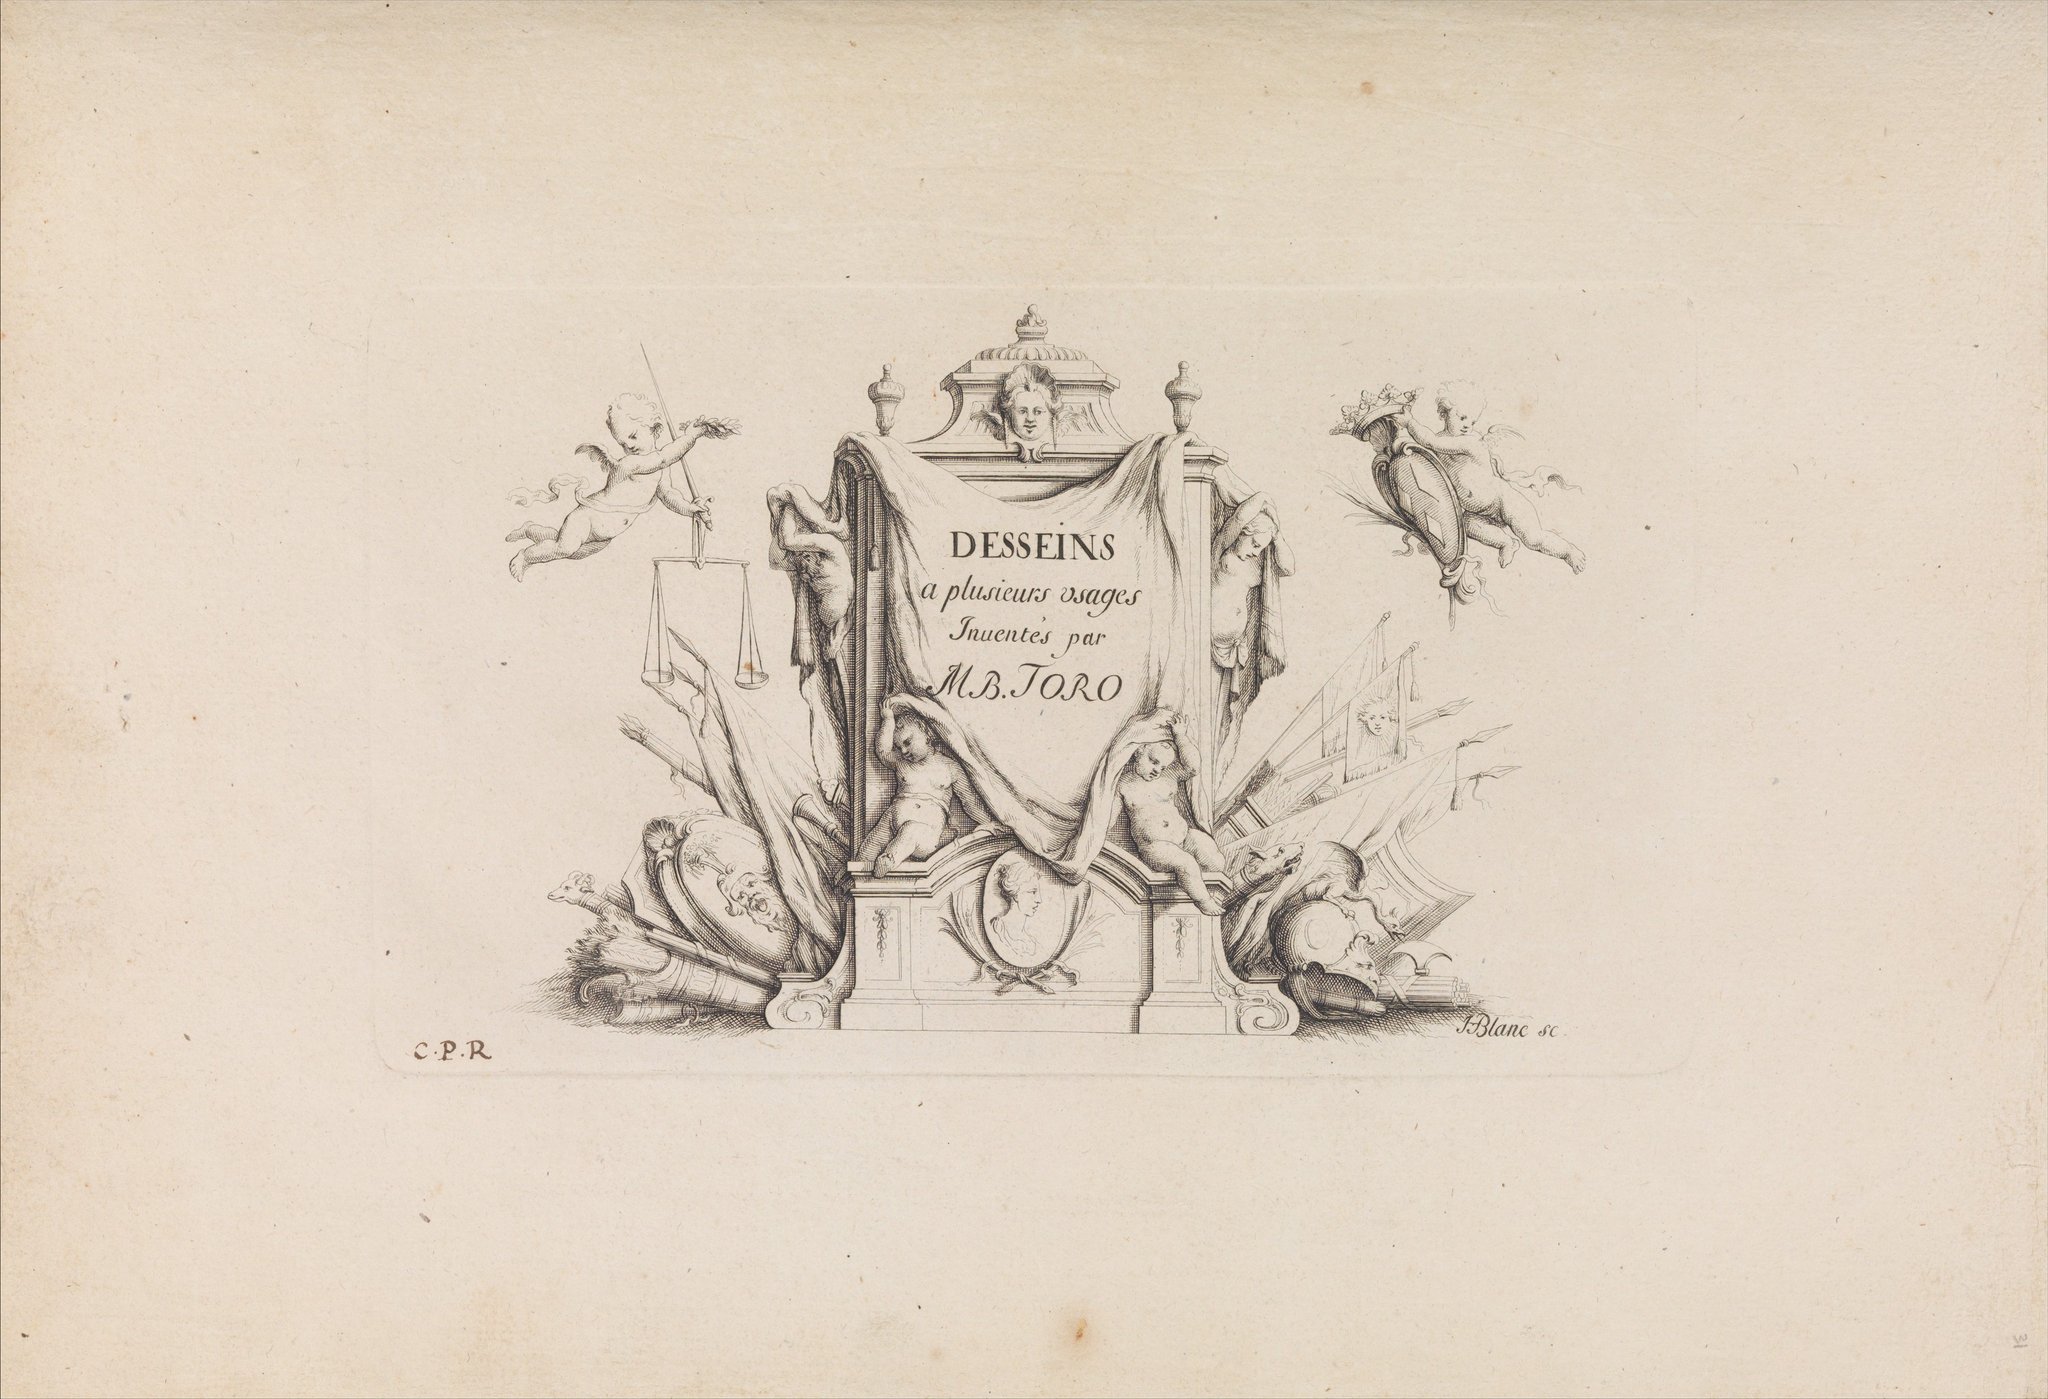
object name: album print ornament architecture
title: Desseins a Plusieurs Usages Inventés par M. B. Toro (Title Page)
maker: jean bernard toro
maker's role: designer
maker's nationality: french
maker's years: 1672-1731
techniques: etching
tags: women